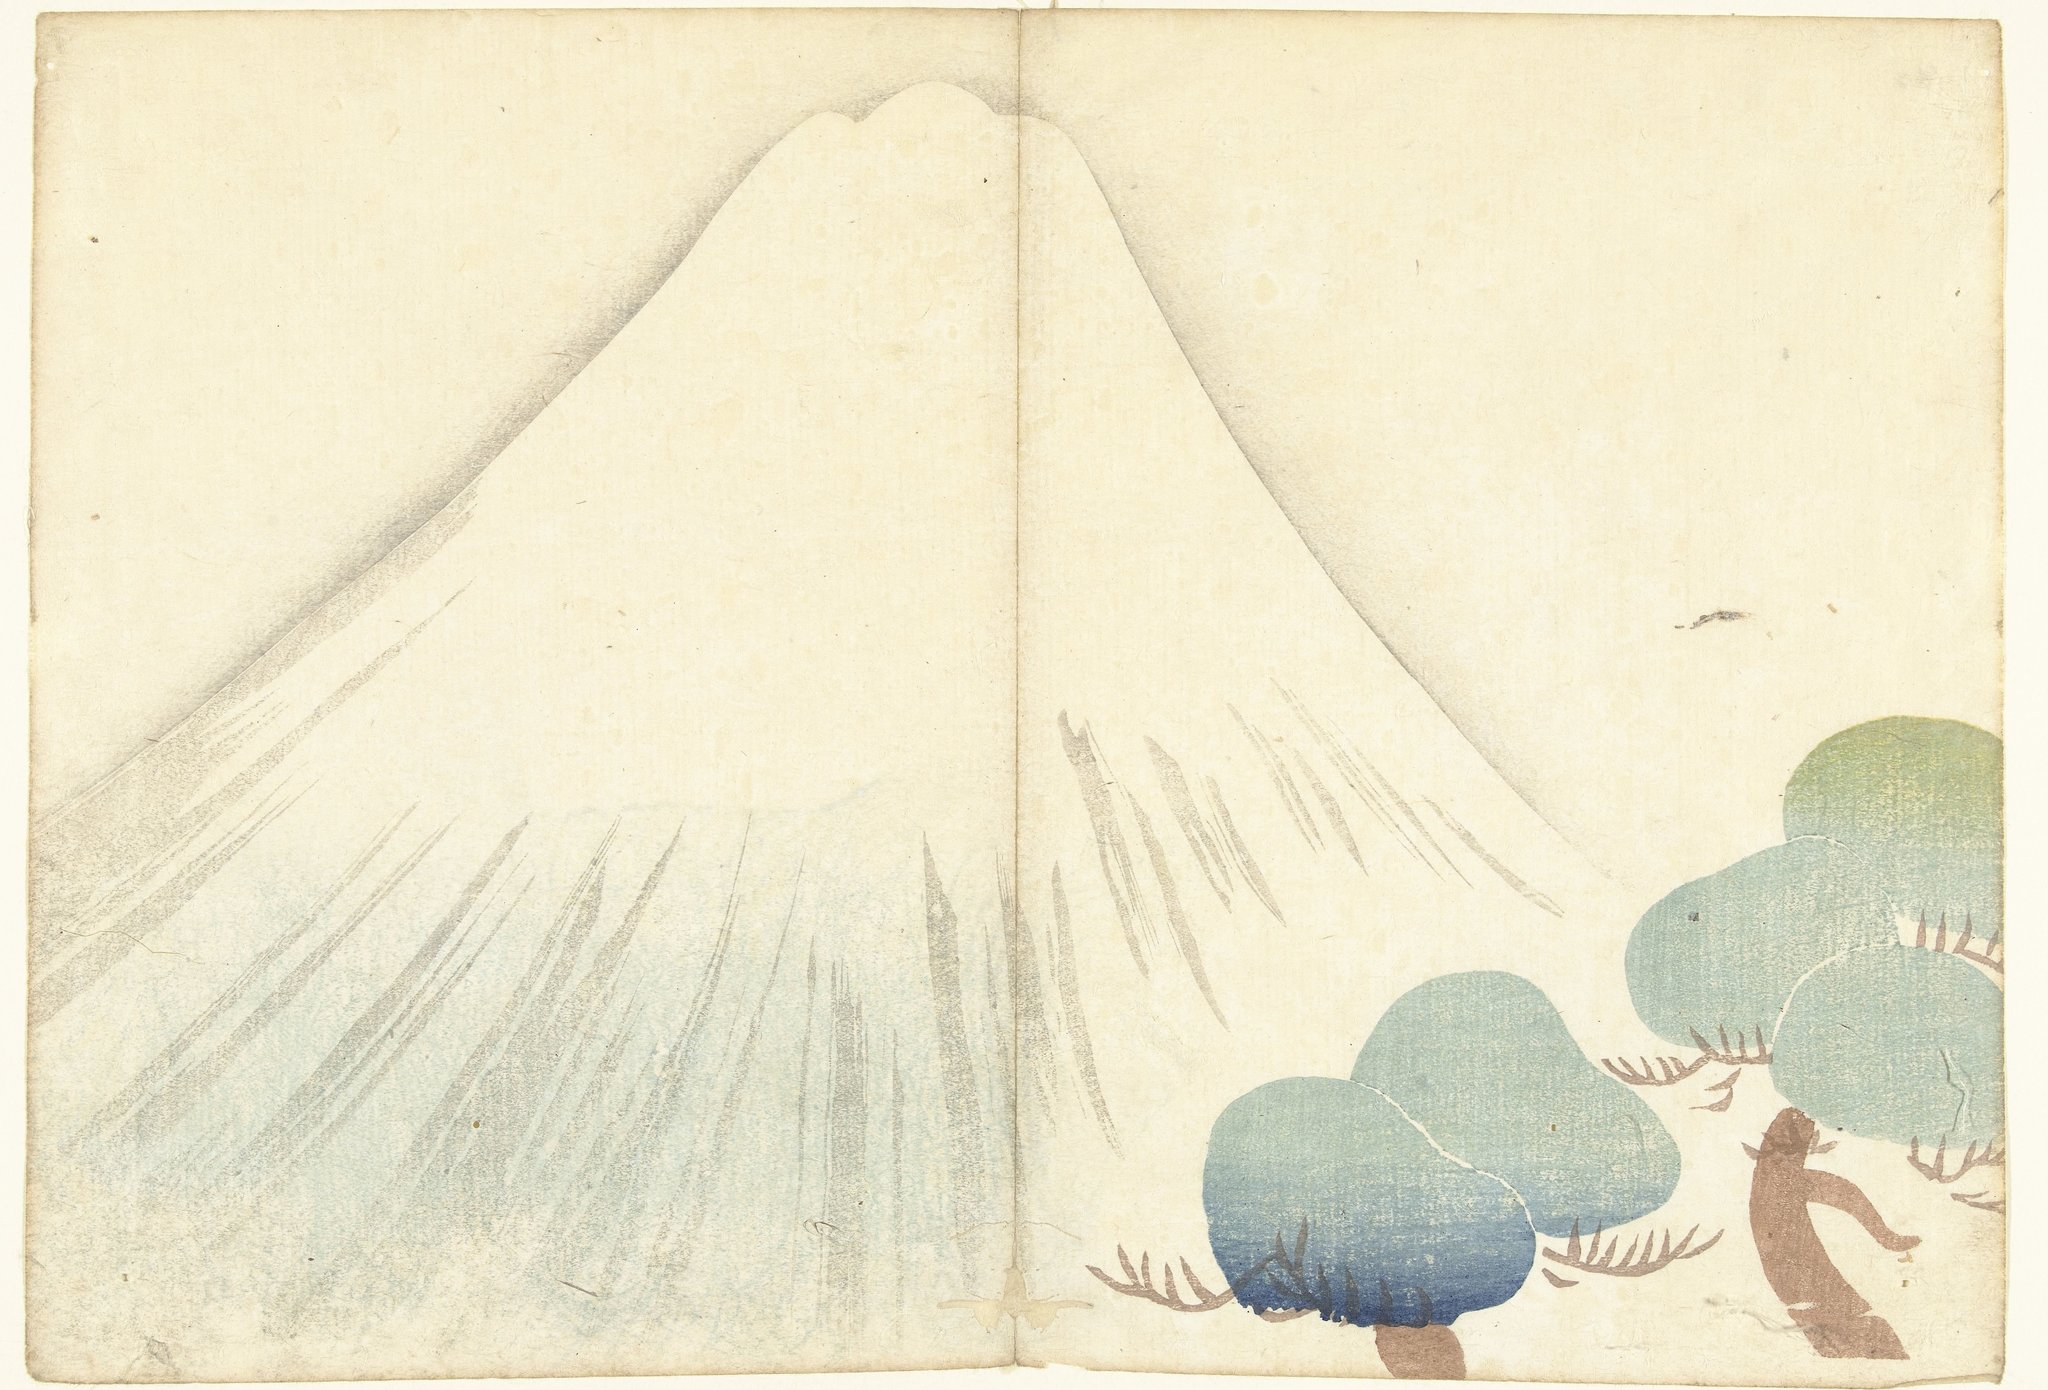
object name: print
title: Fuji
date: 1826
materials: paper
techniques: woodcut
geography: edo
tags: mountain-top, peak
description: De berg Fuji met pijnbomen op de voorgrond.